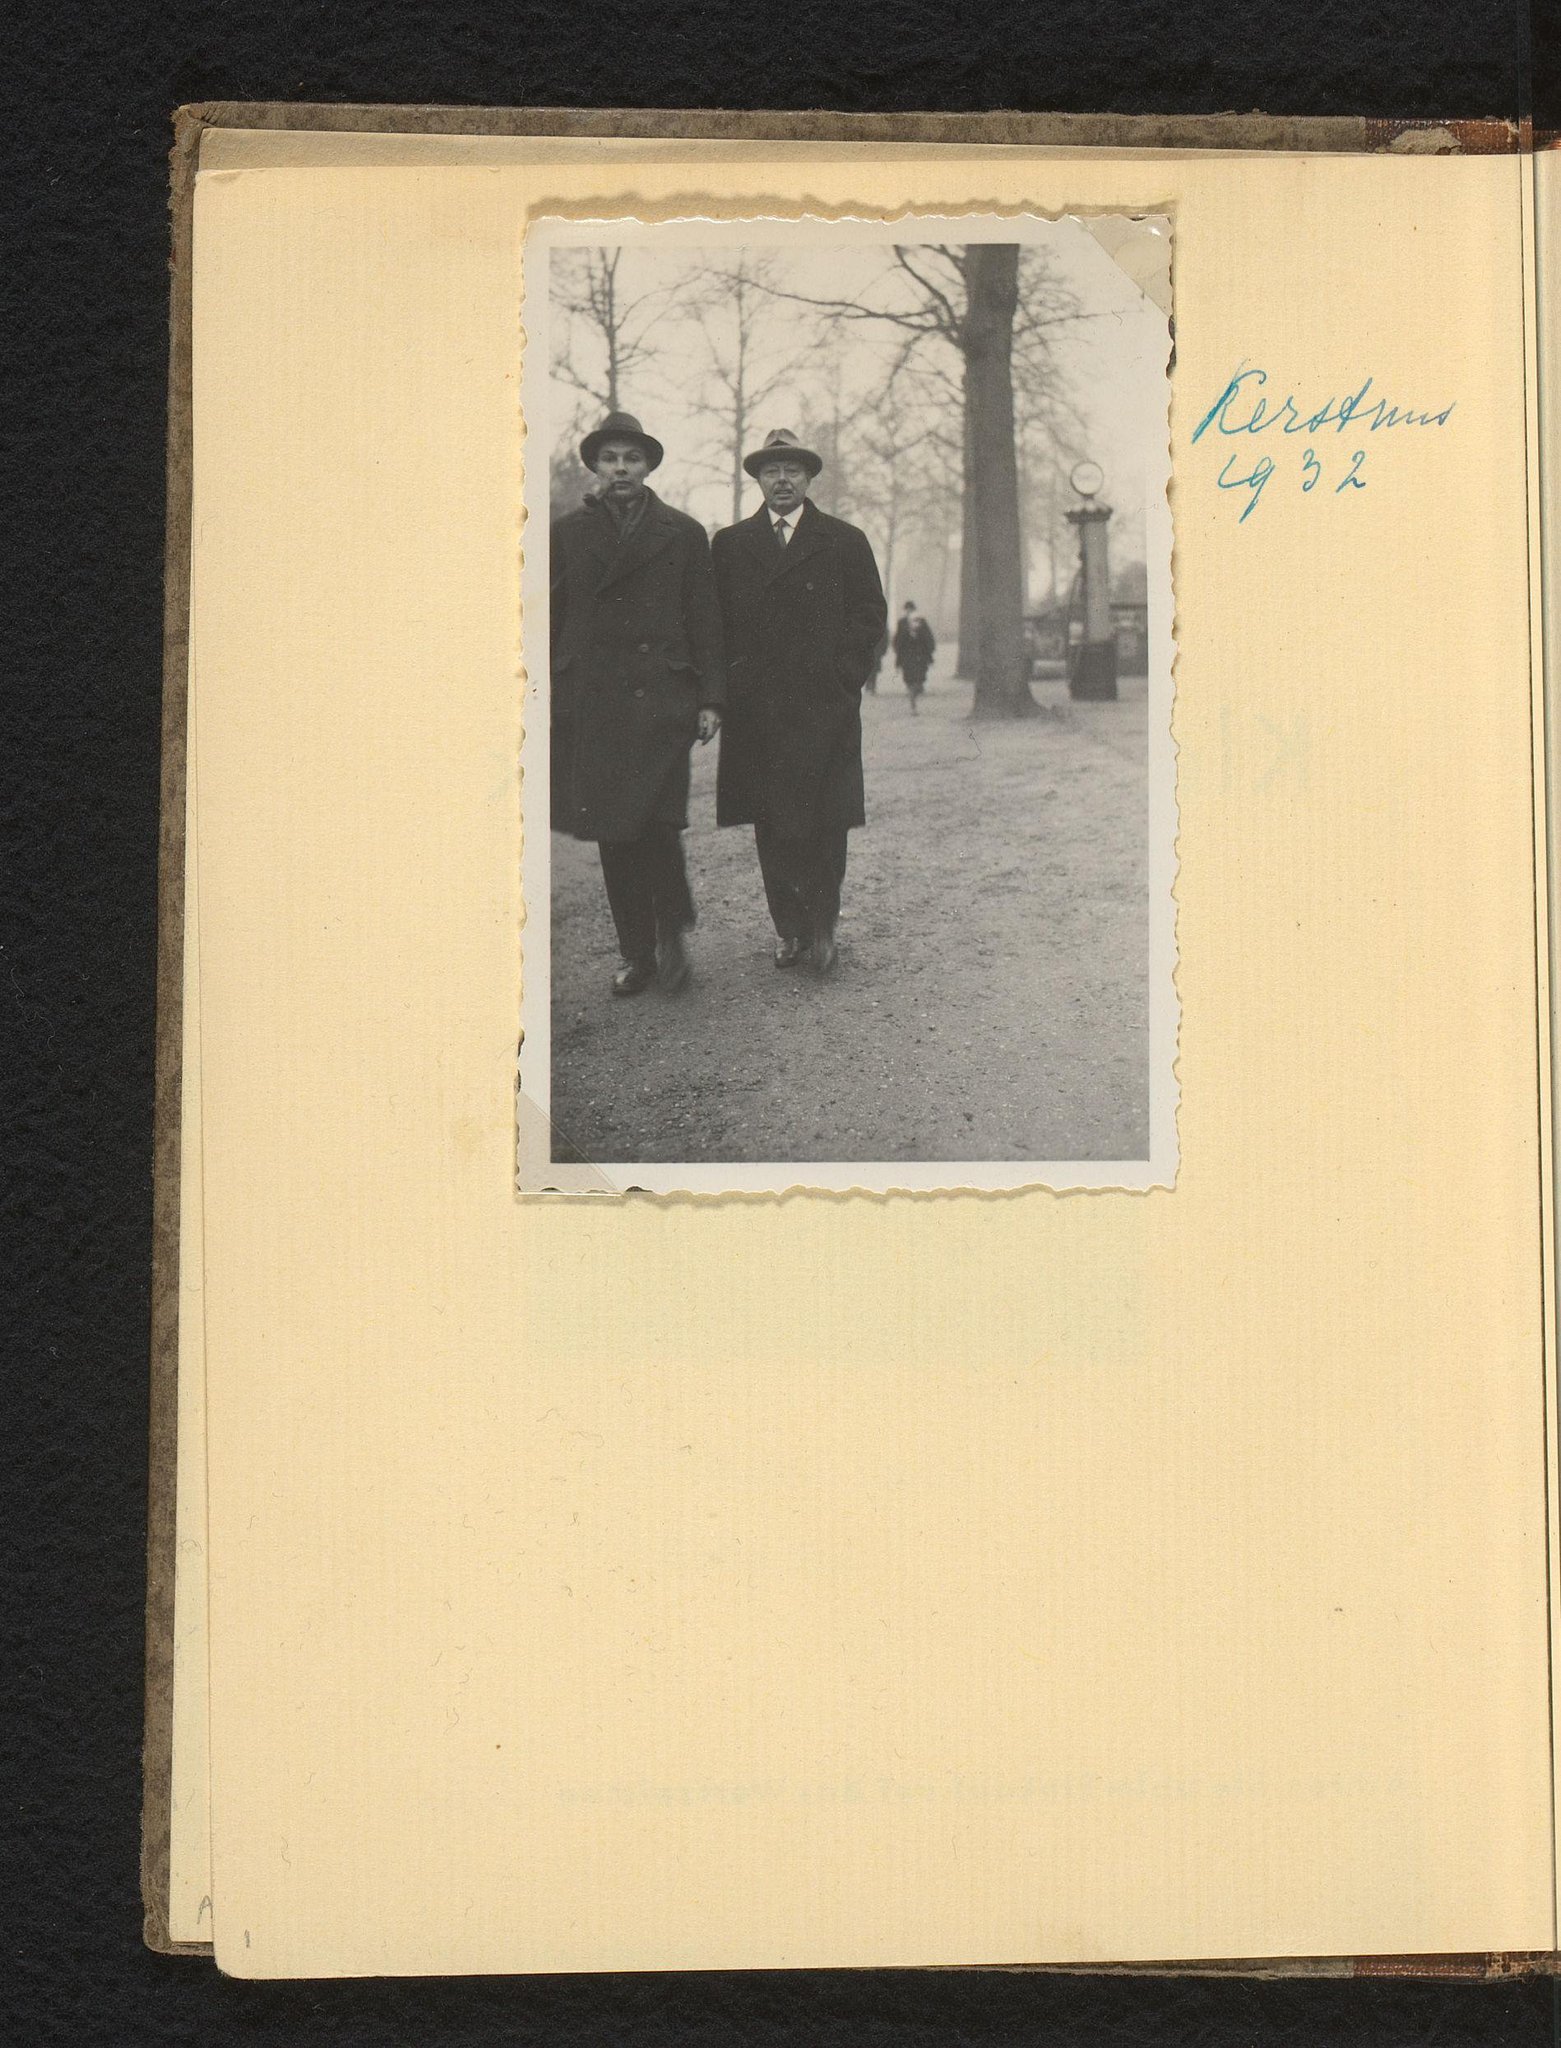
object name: photograph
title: Mannen lopend over een laan, Baarn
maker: Anonymous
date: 1912-1932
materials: paper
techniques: gelatin silver print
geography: baarn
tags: strolling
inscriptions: inscription: ‘Kerstmis/ 1932’